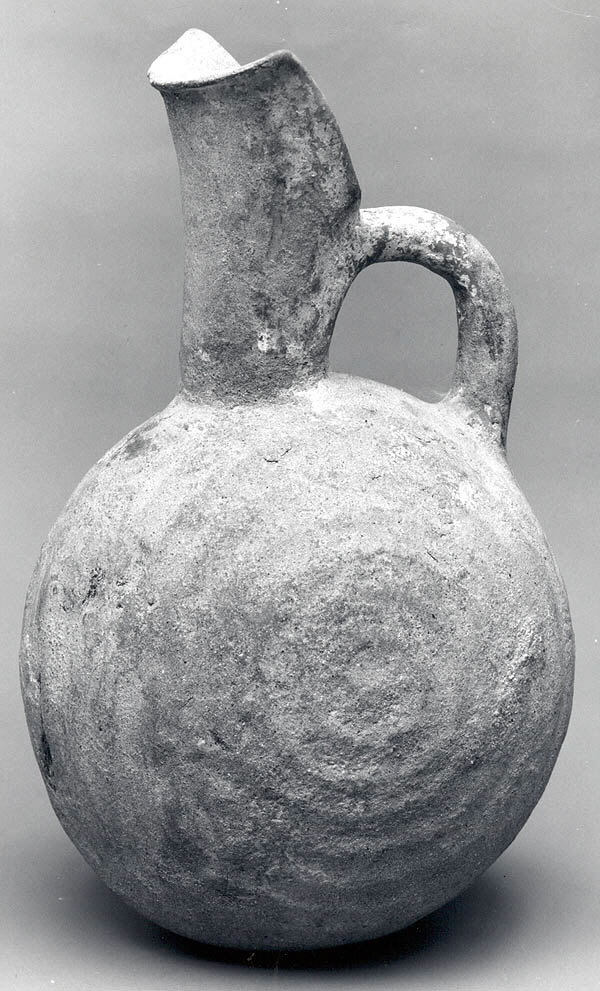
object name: jug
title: Spouted jug with raised concentric circles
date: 2700-2400 BCE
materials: ceramic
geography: northwestern anatolia